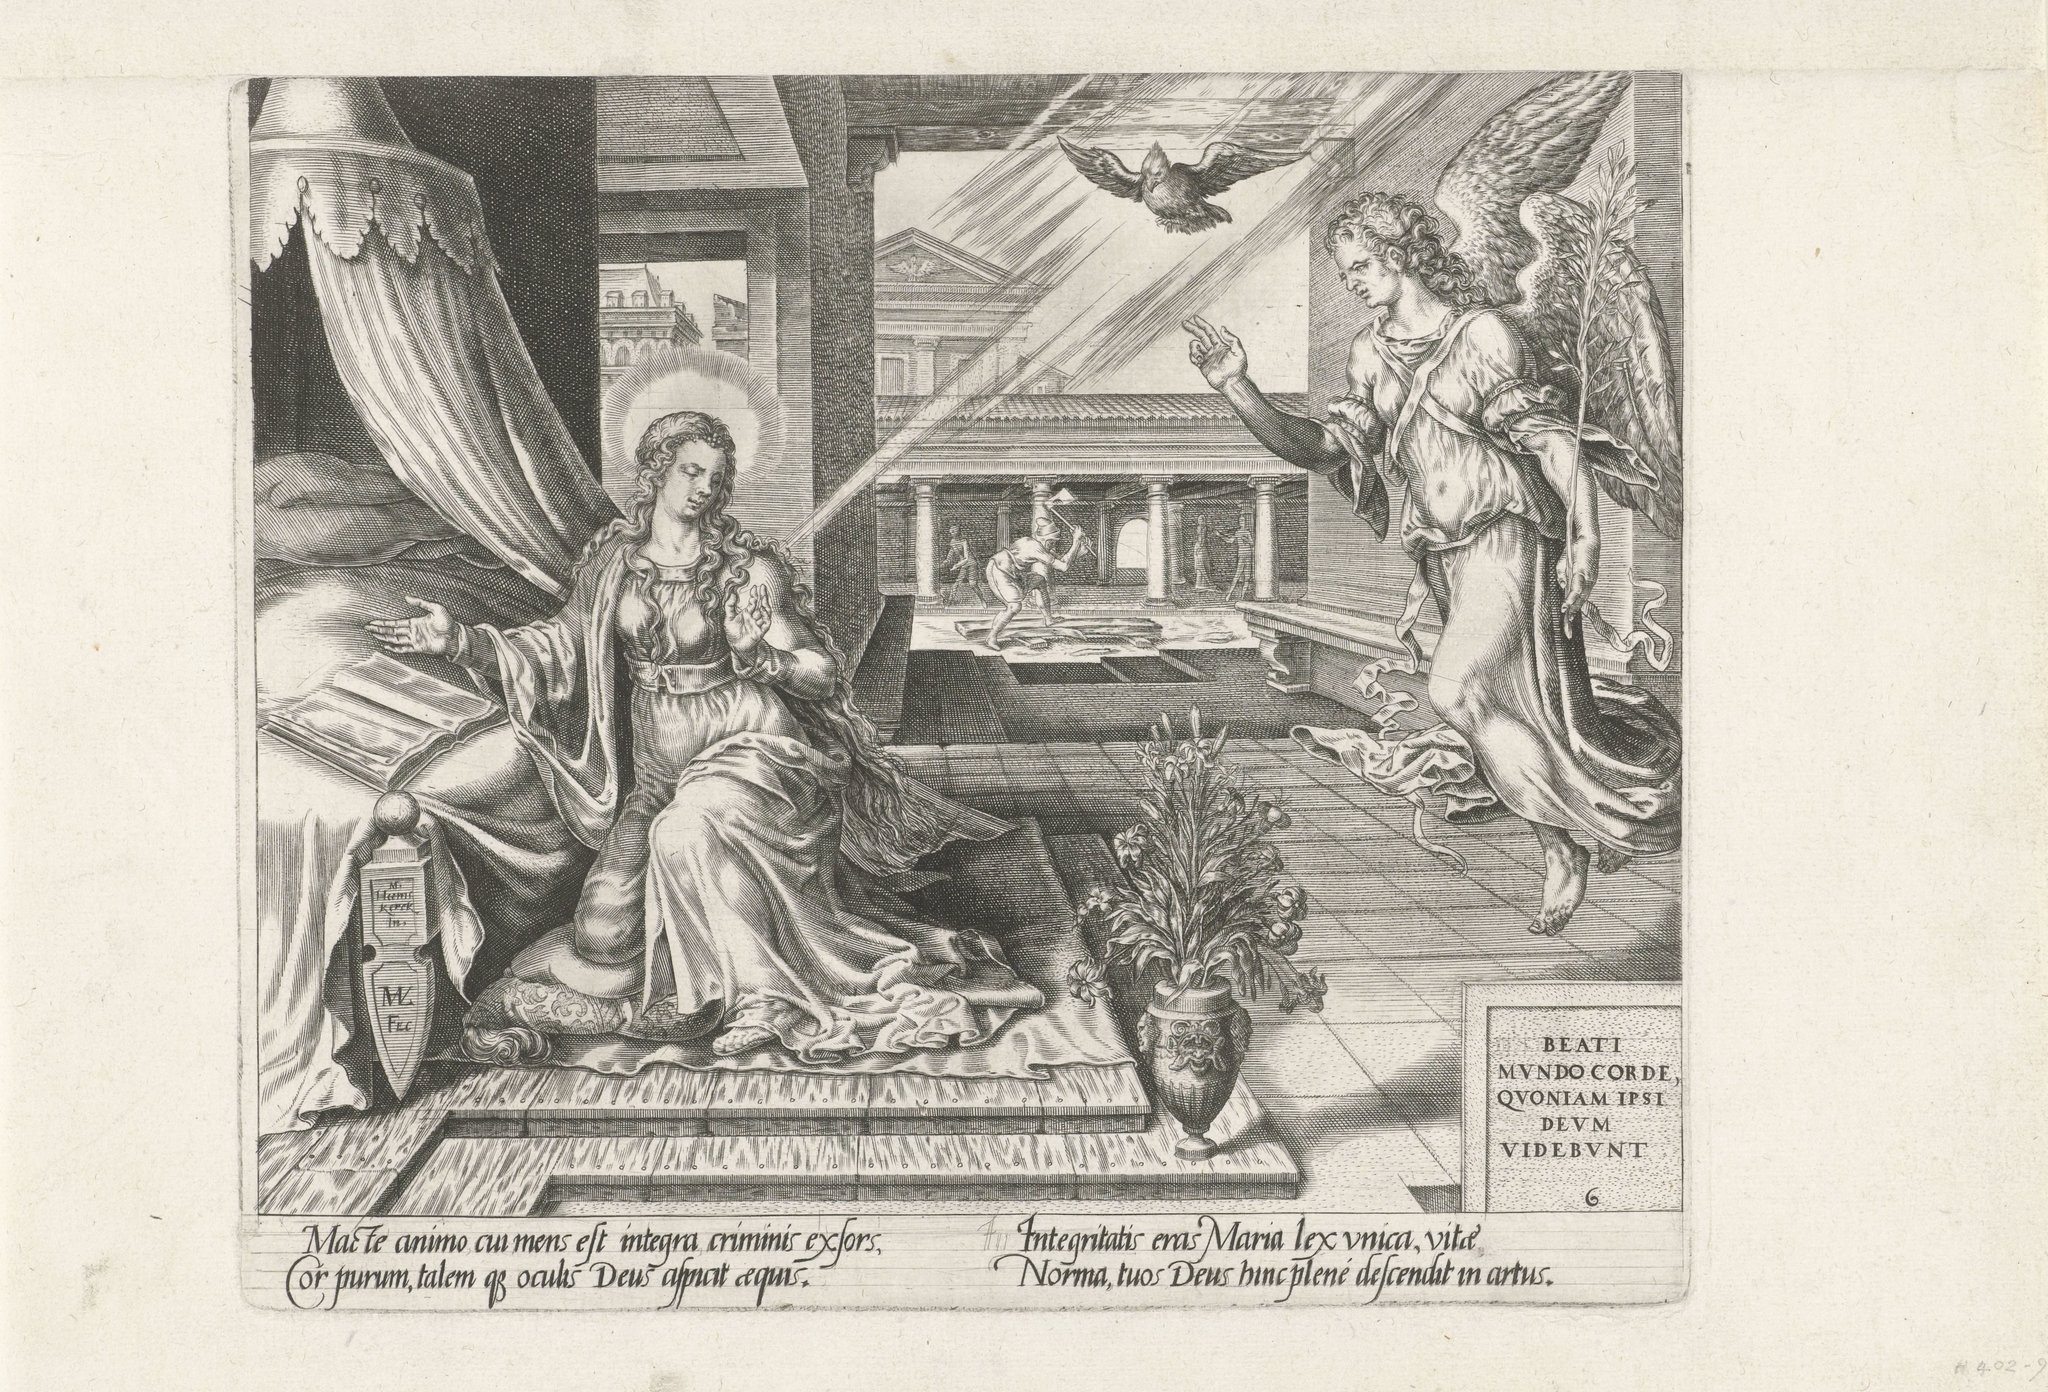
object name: print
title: Zalig wie zuiver van hart zijn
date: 1564-1568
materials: paper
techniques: engraving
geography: amsterdam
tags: blessed are the pure in heart, the annunciation: mary, usually reading, is visited by the angel (sometimes a woman overhears the conversation) - aa - mary to the left, the angel to the right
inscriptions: collector's mark: Lugt 2760, collector's mark: Lugt 2228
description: De engel Gabriël kondigt aan Maria aan dat ze zwanger zal worden. Maria zit geknield bij een bed, waarop een opengeslagen boek ligt. De Heilige Geest daalt als een duif neer. Op de achtergrond hakt Jozef hout. Prent maakt deel uit van een serie over de acht zaligsprekingen van Christus en illustreert de zaligspreking: Zalig wie zuiver van hart zijn. In de rechter benedenhoek deze tekst uit Mat. 5:8 in het Latijn. Onderaan in de marge een vers in het Latijn over de zaligspreking en de voorstelling.